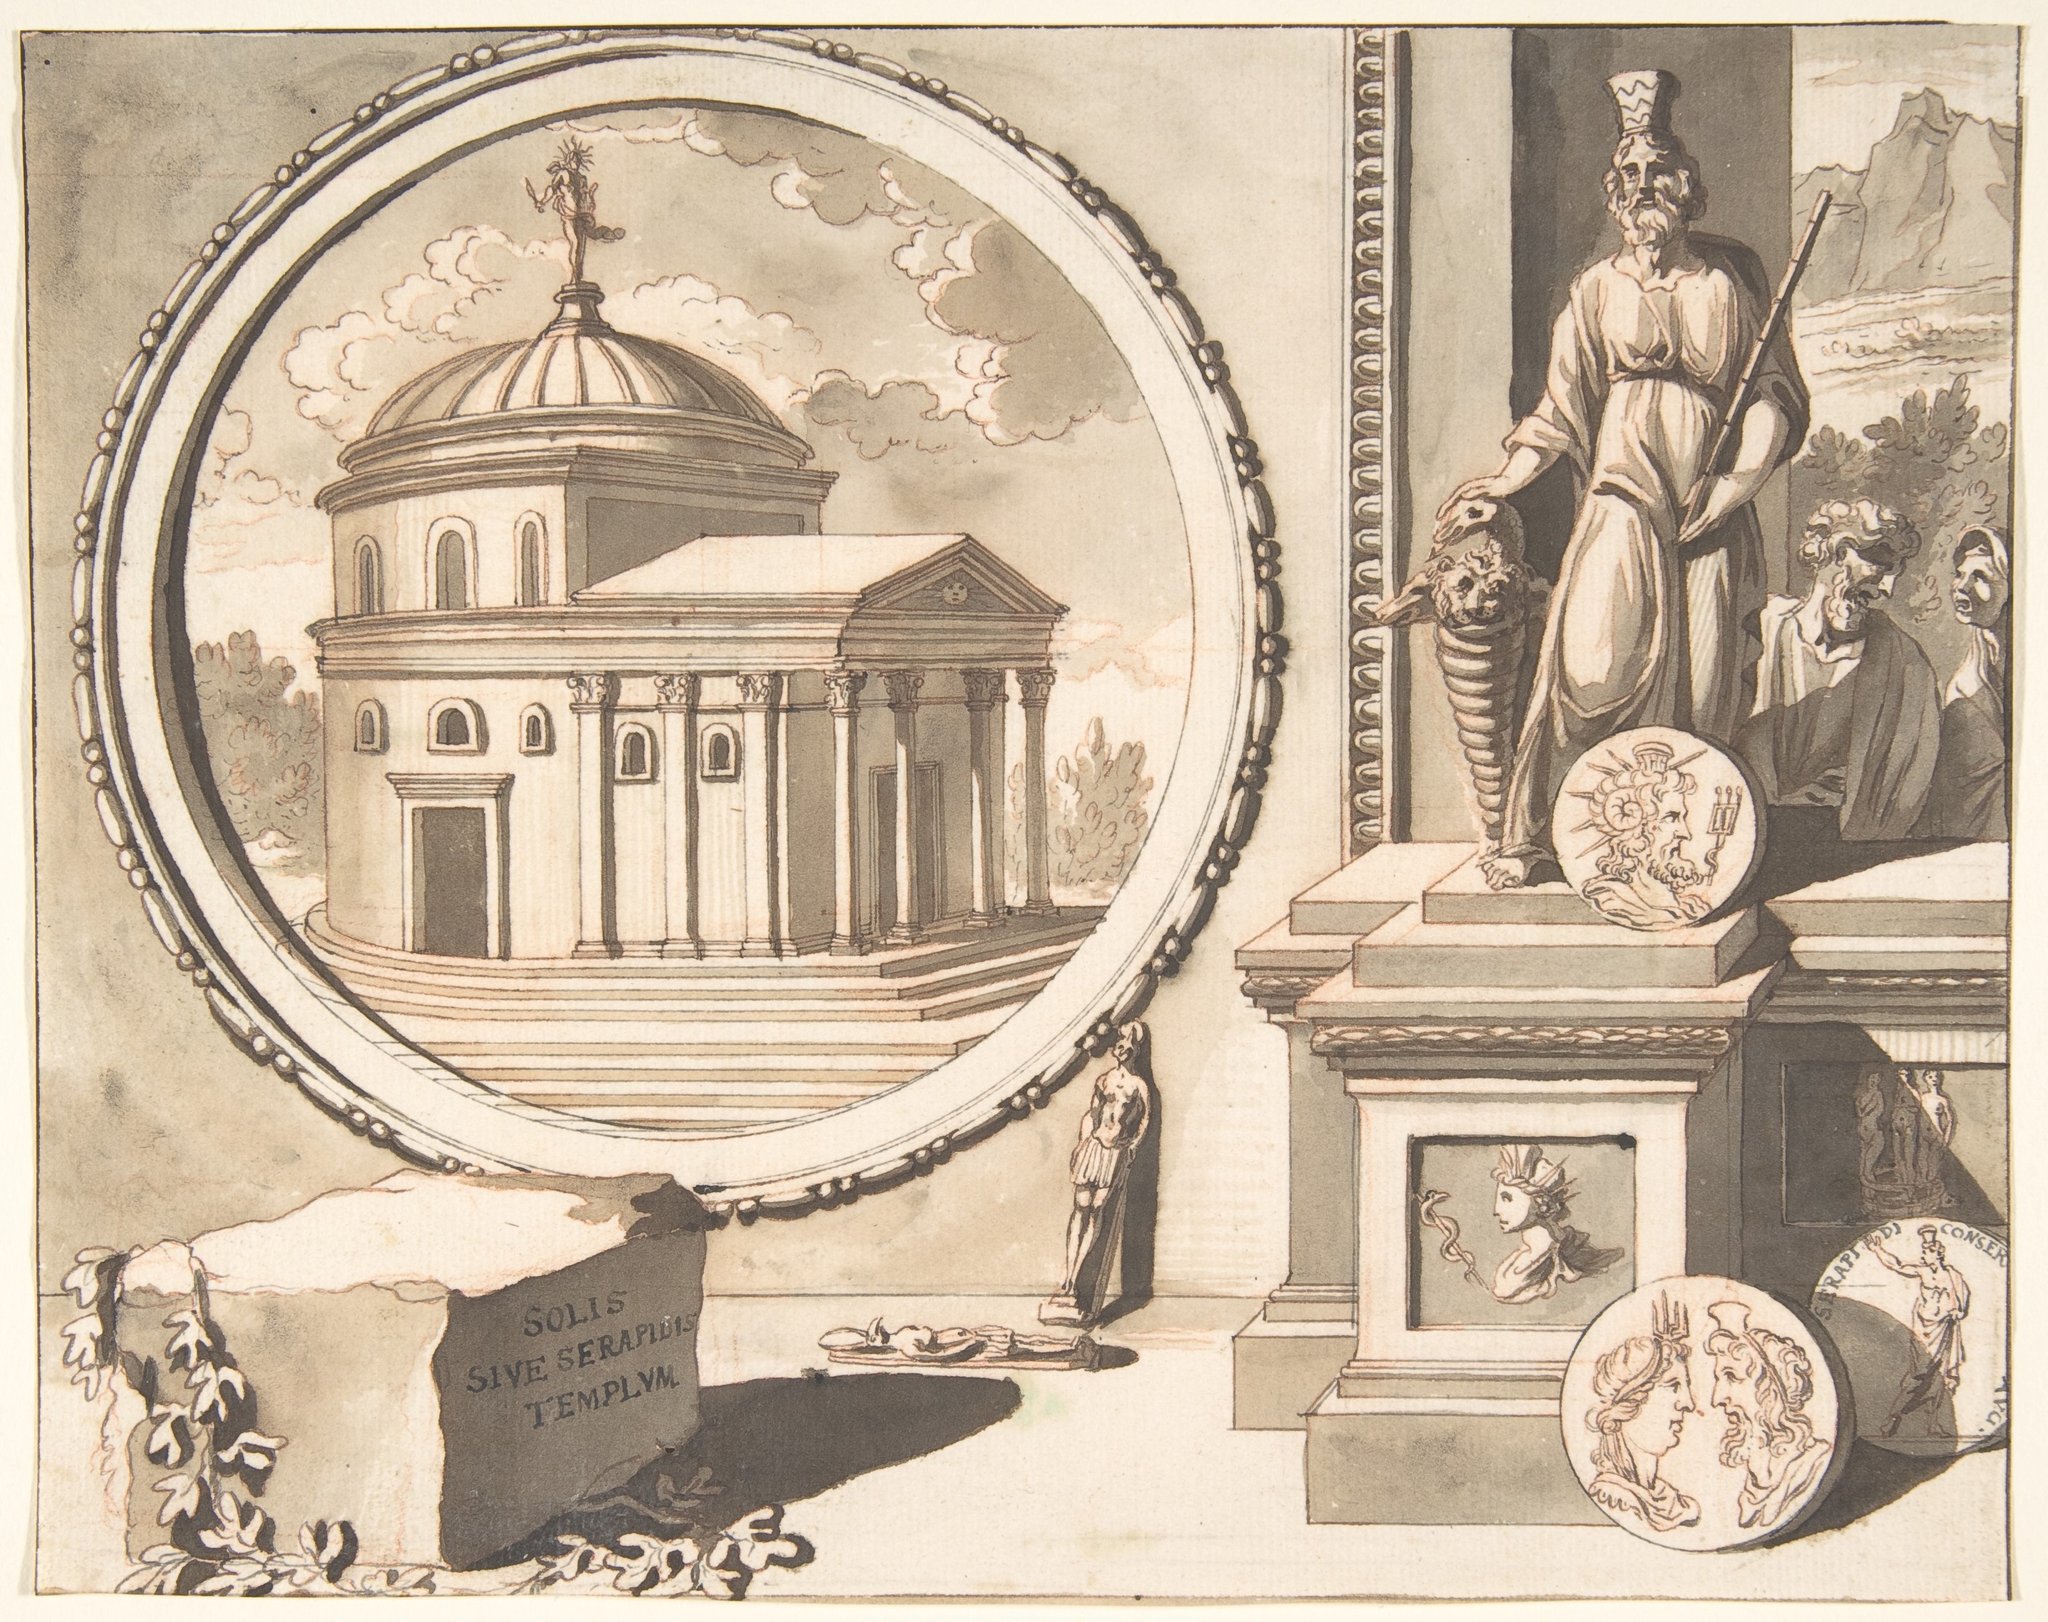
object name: drawing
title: A Recontruction of the So-Called Temple of Serapidis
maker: jan goeree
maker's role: artist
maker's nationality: dutch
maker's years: 1670-1731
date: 1704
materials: chalk, ink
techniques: brush, pen, wash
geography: italy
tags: temples